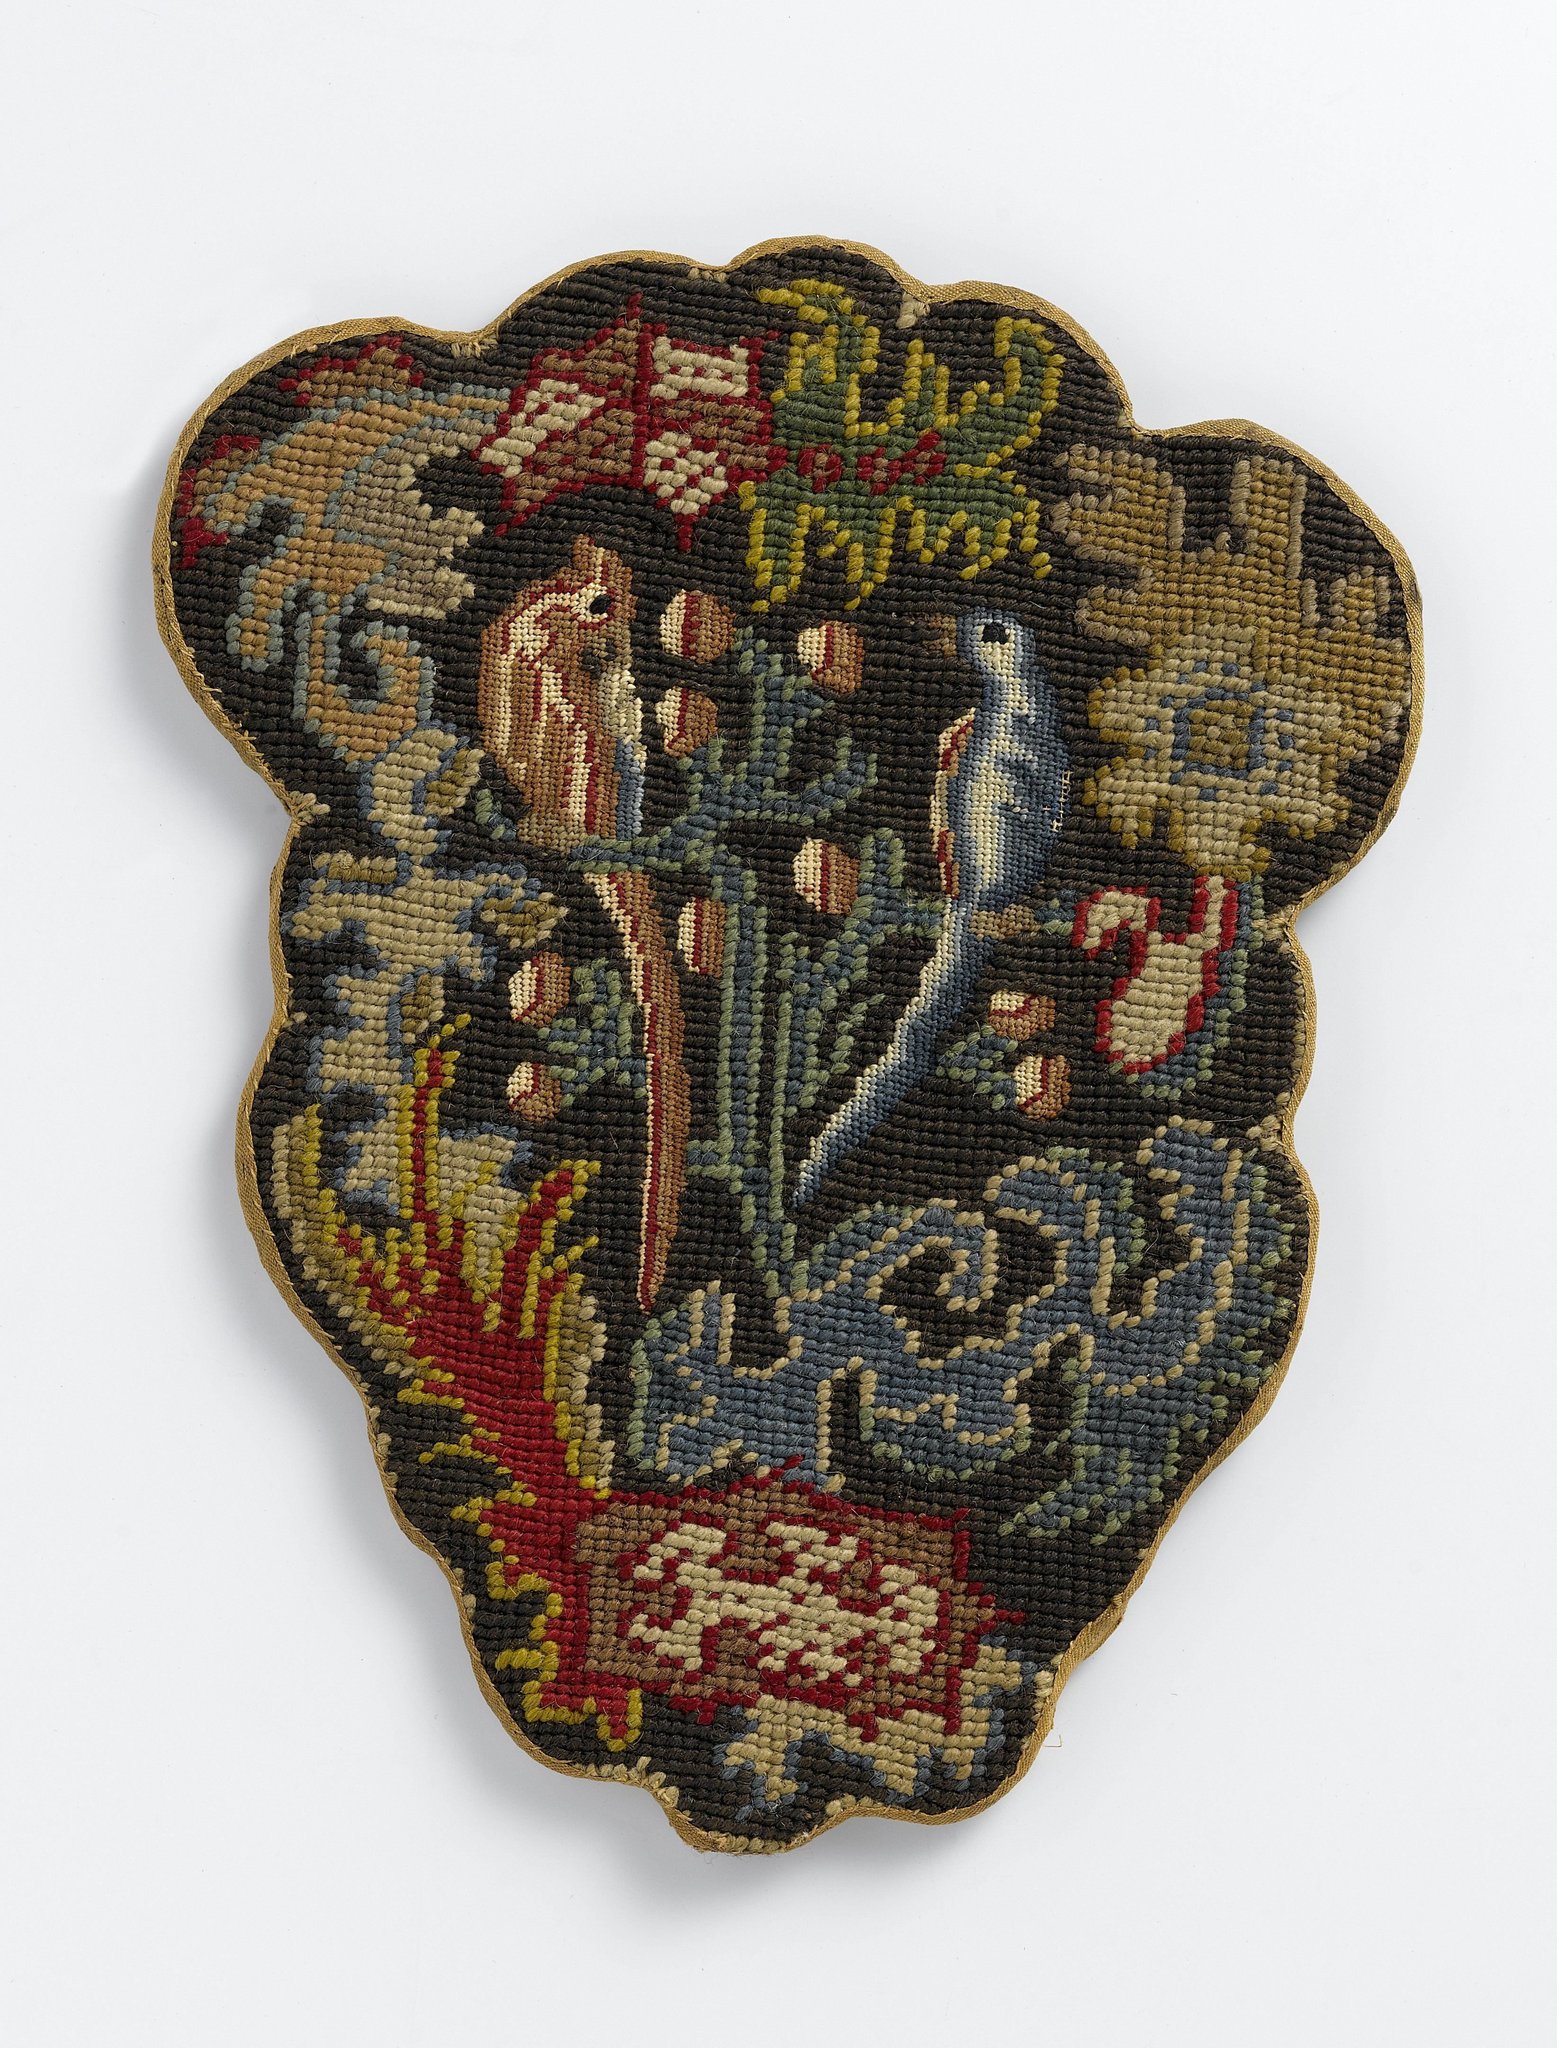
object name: vuurscherm waaier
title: Vuurscherm van linnen, gespannen over geschulpt, houten(?) frame, aan de voorkant geborduurd met veelkleurige wol en aan de achterkant bedrukt met een brullende leeuw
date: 1688-1720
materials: linen, ink, wood, wool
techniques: embroidered, printing, tensioning, weave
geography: northern netherlands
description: Écran of parafeu. Het onregelmatig geschulpte scherm is aan de voorkant geborduurd met veelkleurige wol in petit-point en gros-point. Centraal in het asymmetrisch opgebouwde patroon zitten twee elkaar toegewende vogels op een tak, temidden van bloem- en bladmotieven. De lange staarten en de barokke opbouw van het patroon zijn ongebruikelijk en vooralsnog niet terug te voeren op voorbeelden uit patroonboeken. De achterkant van het scherm is bedrukt met een bruinbeige, brullende leeuw met een vuurrode tong. Deze afbeelding is terug te vinden in een album met prenten van Johan Teyler in het Rijksprentenkabinet (inv. RP-P-1955-255) en in een uitgebreider album in het British Museum, London (inv. 1871-12-9-5027(25)).